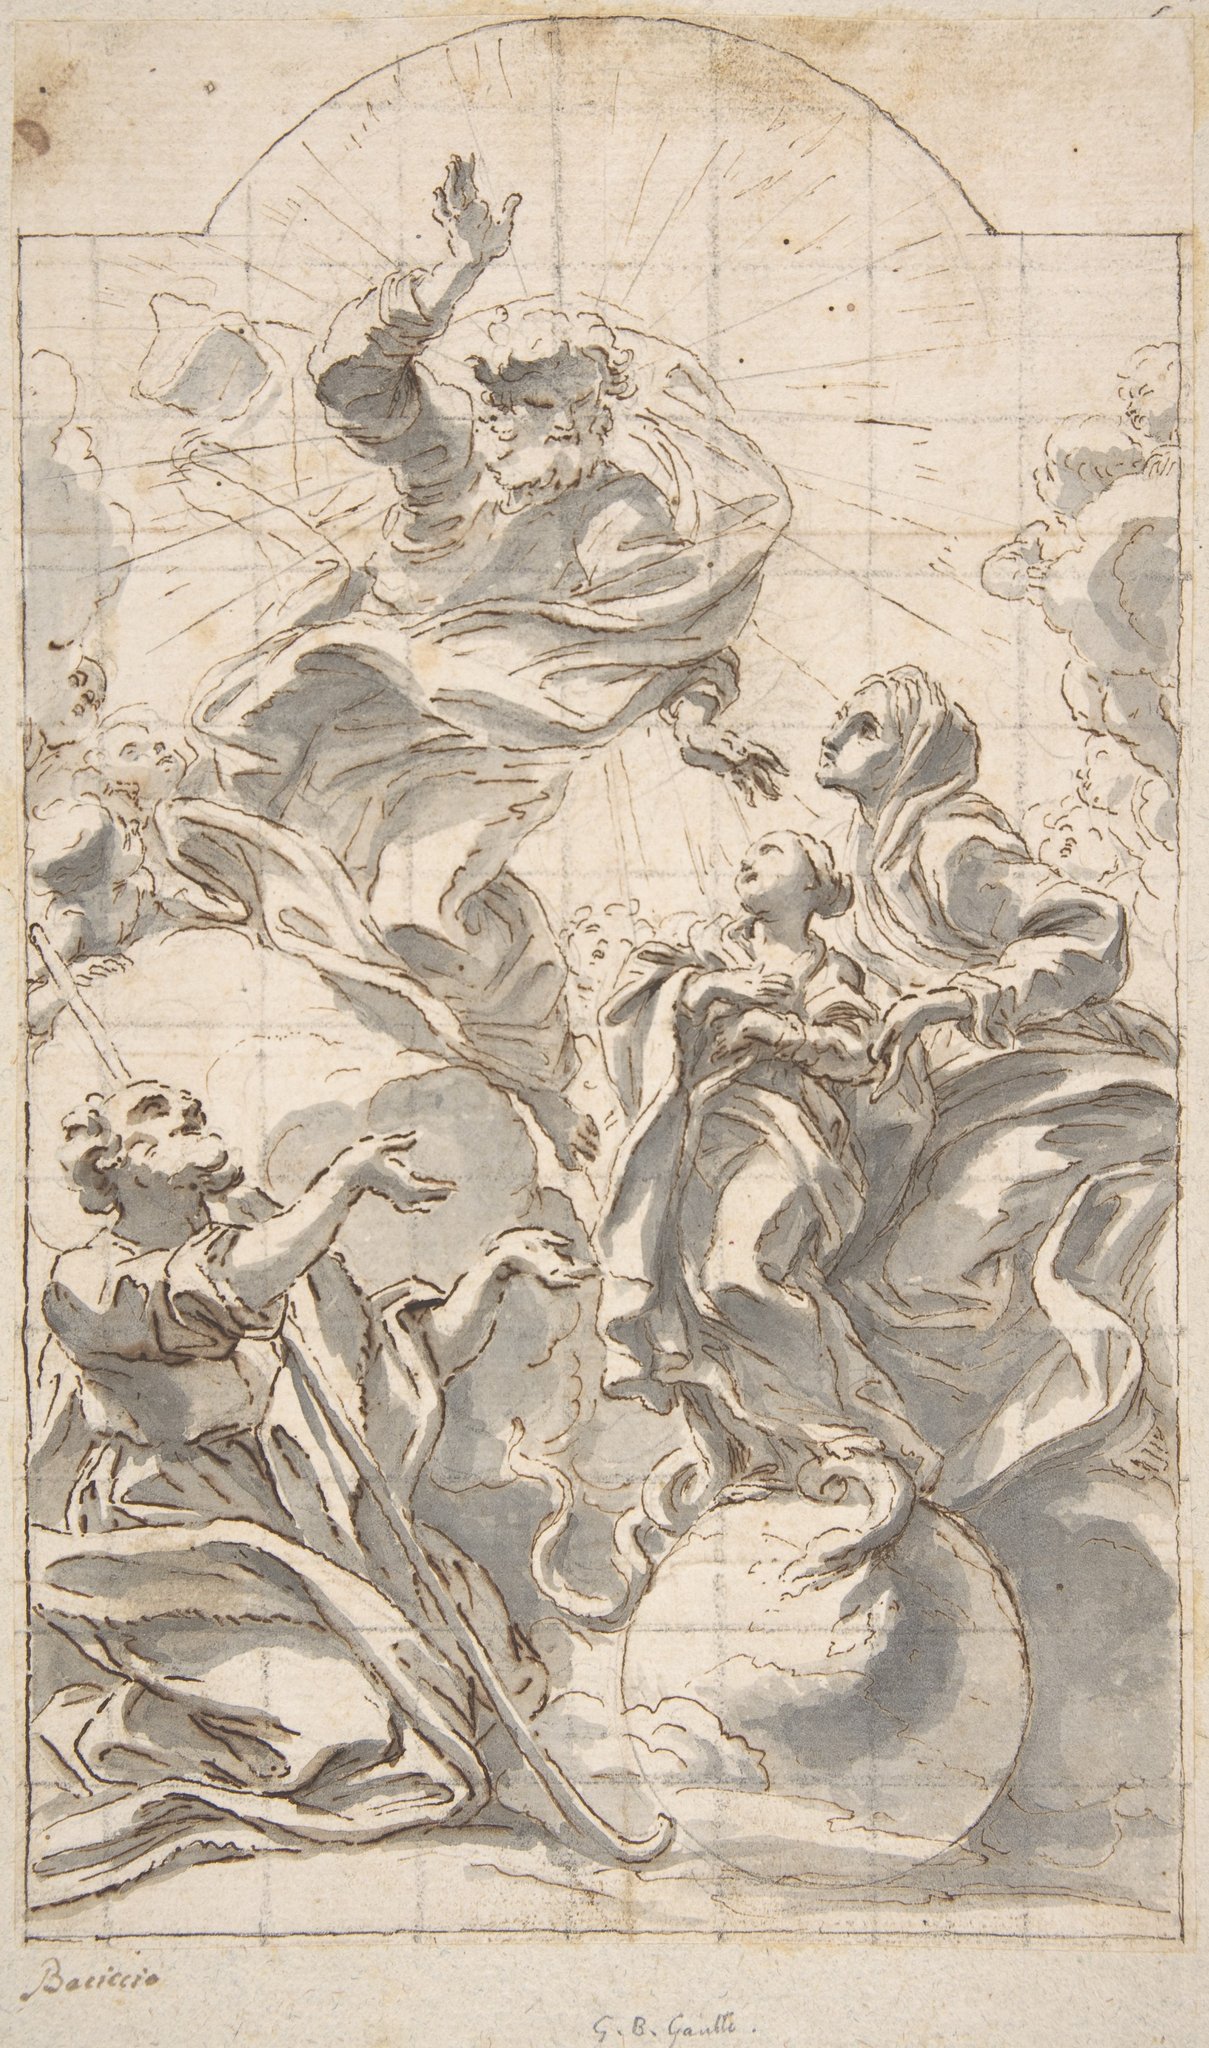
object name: drawing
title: Allegory of the Immaculate Conception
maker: giovanni battista gaulli (il baciccio)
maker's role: artist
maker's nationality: italian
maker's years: 1639-1709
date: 1639-1709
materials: chalk, ink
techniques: brush, pen, drawing, wash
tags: men,women